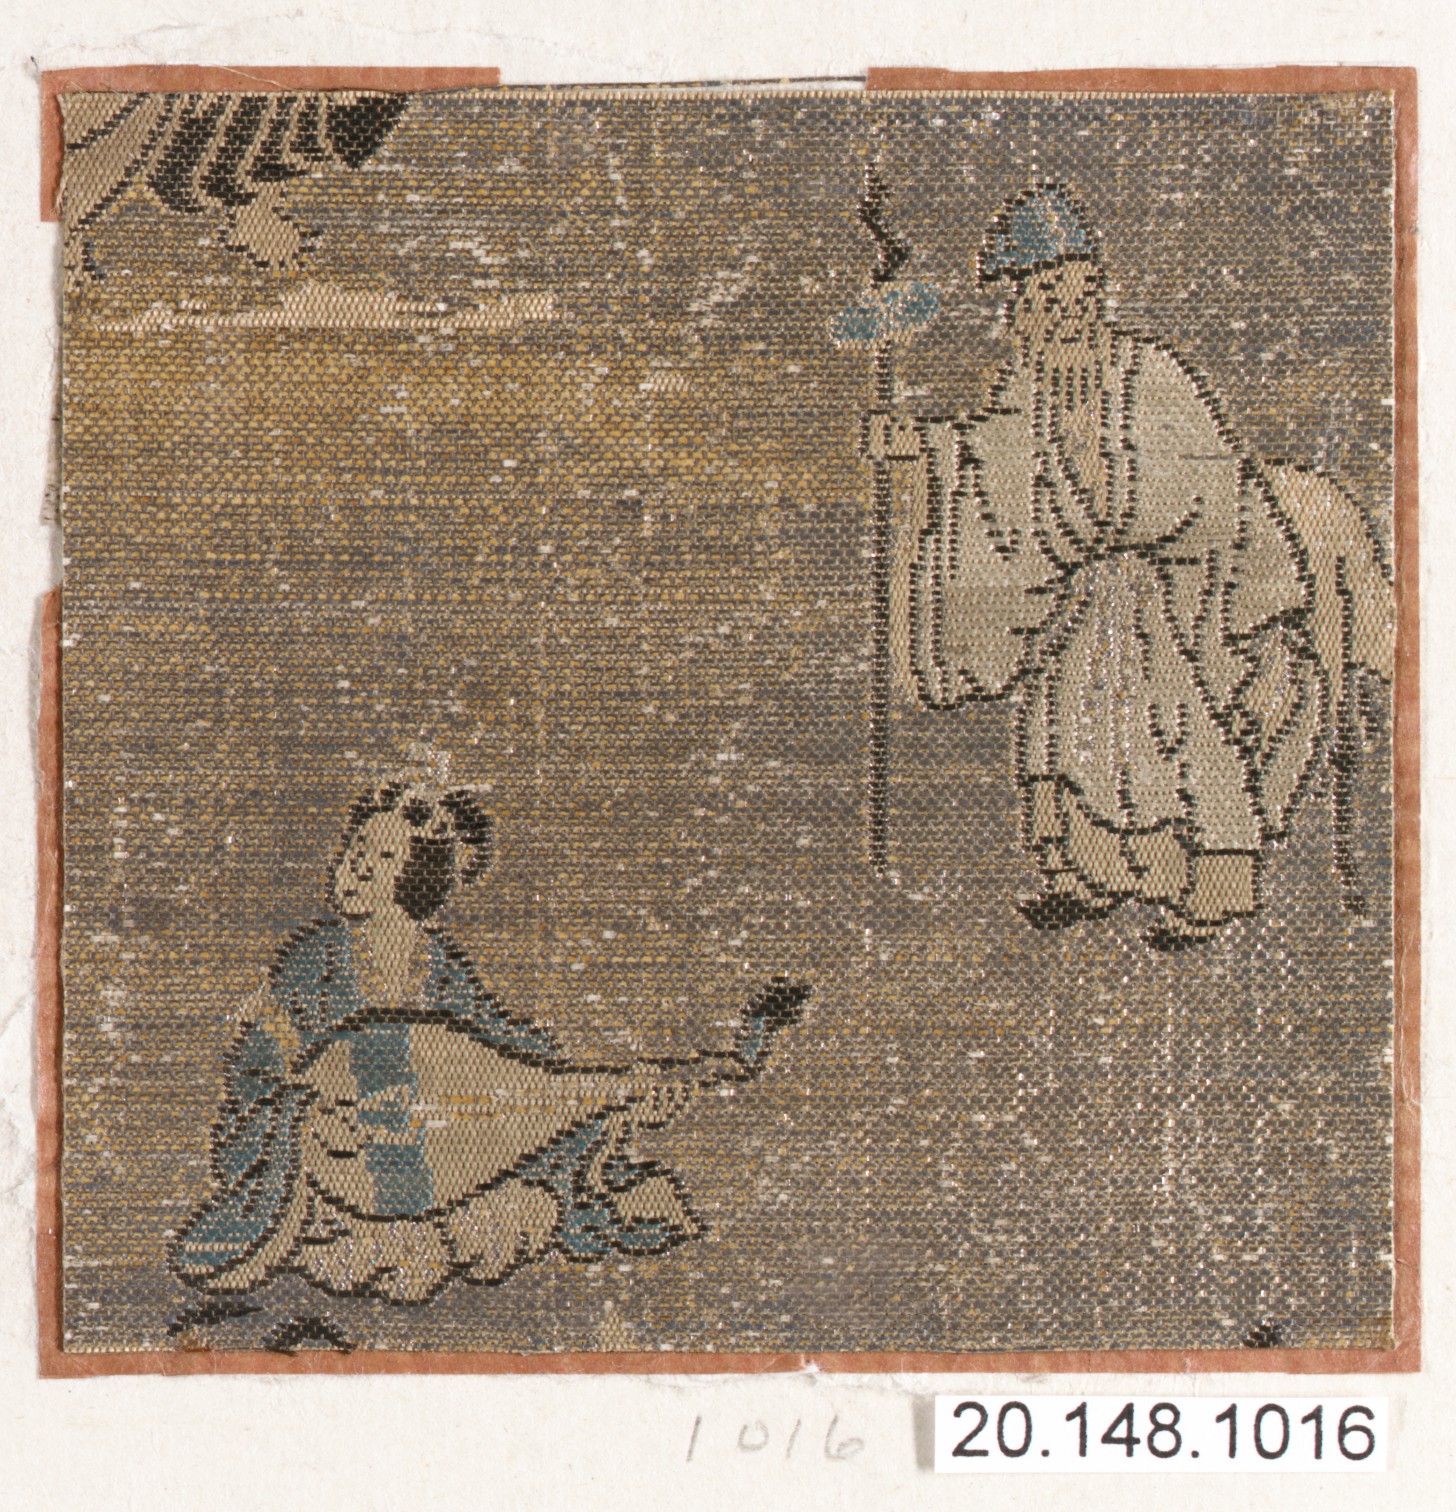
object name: piece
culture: japanese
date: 1701-1800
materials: silk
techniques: compound weave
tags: musical instruments,men,women